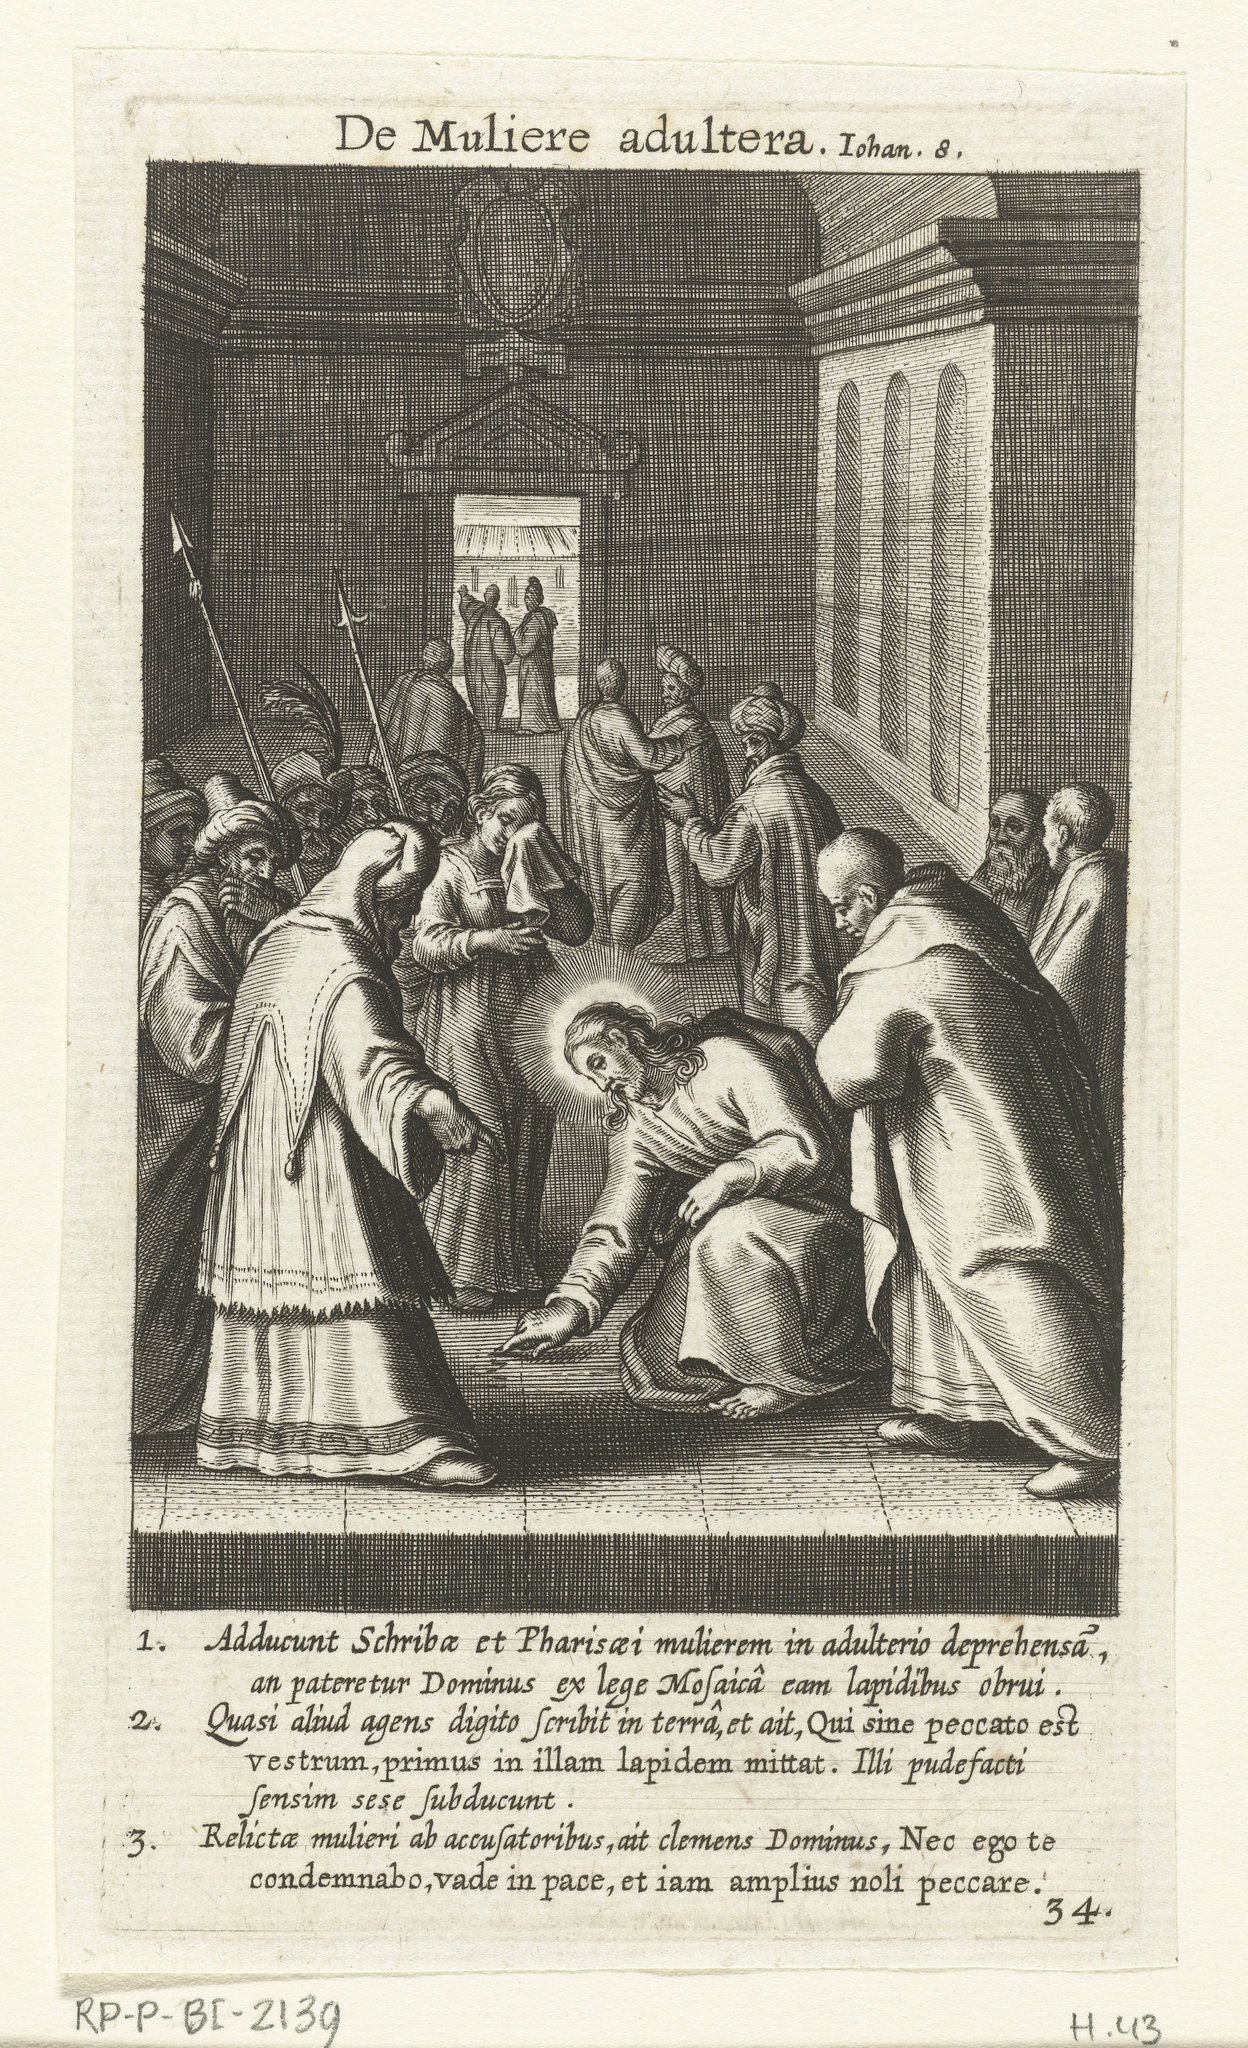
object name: book illustration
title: Christus en de overspelige vrouw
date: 1590-1622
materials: paper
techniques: engraving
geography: antwerp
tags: pharisees bring a woman accused of adultery before christ (john 8:2-11)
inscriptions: collector's mark: Lugt 240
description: Prent uit: Joannes Bourgois, Vitae passionis et mortis Jesu Christi Somini nostri mysteria, Antwerpen Hendrick Aertssens, 1622, afb. 34